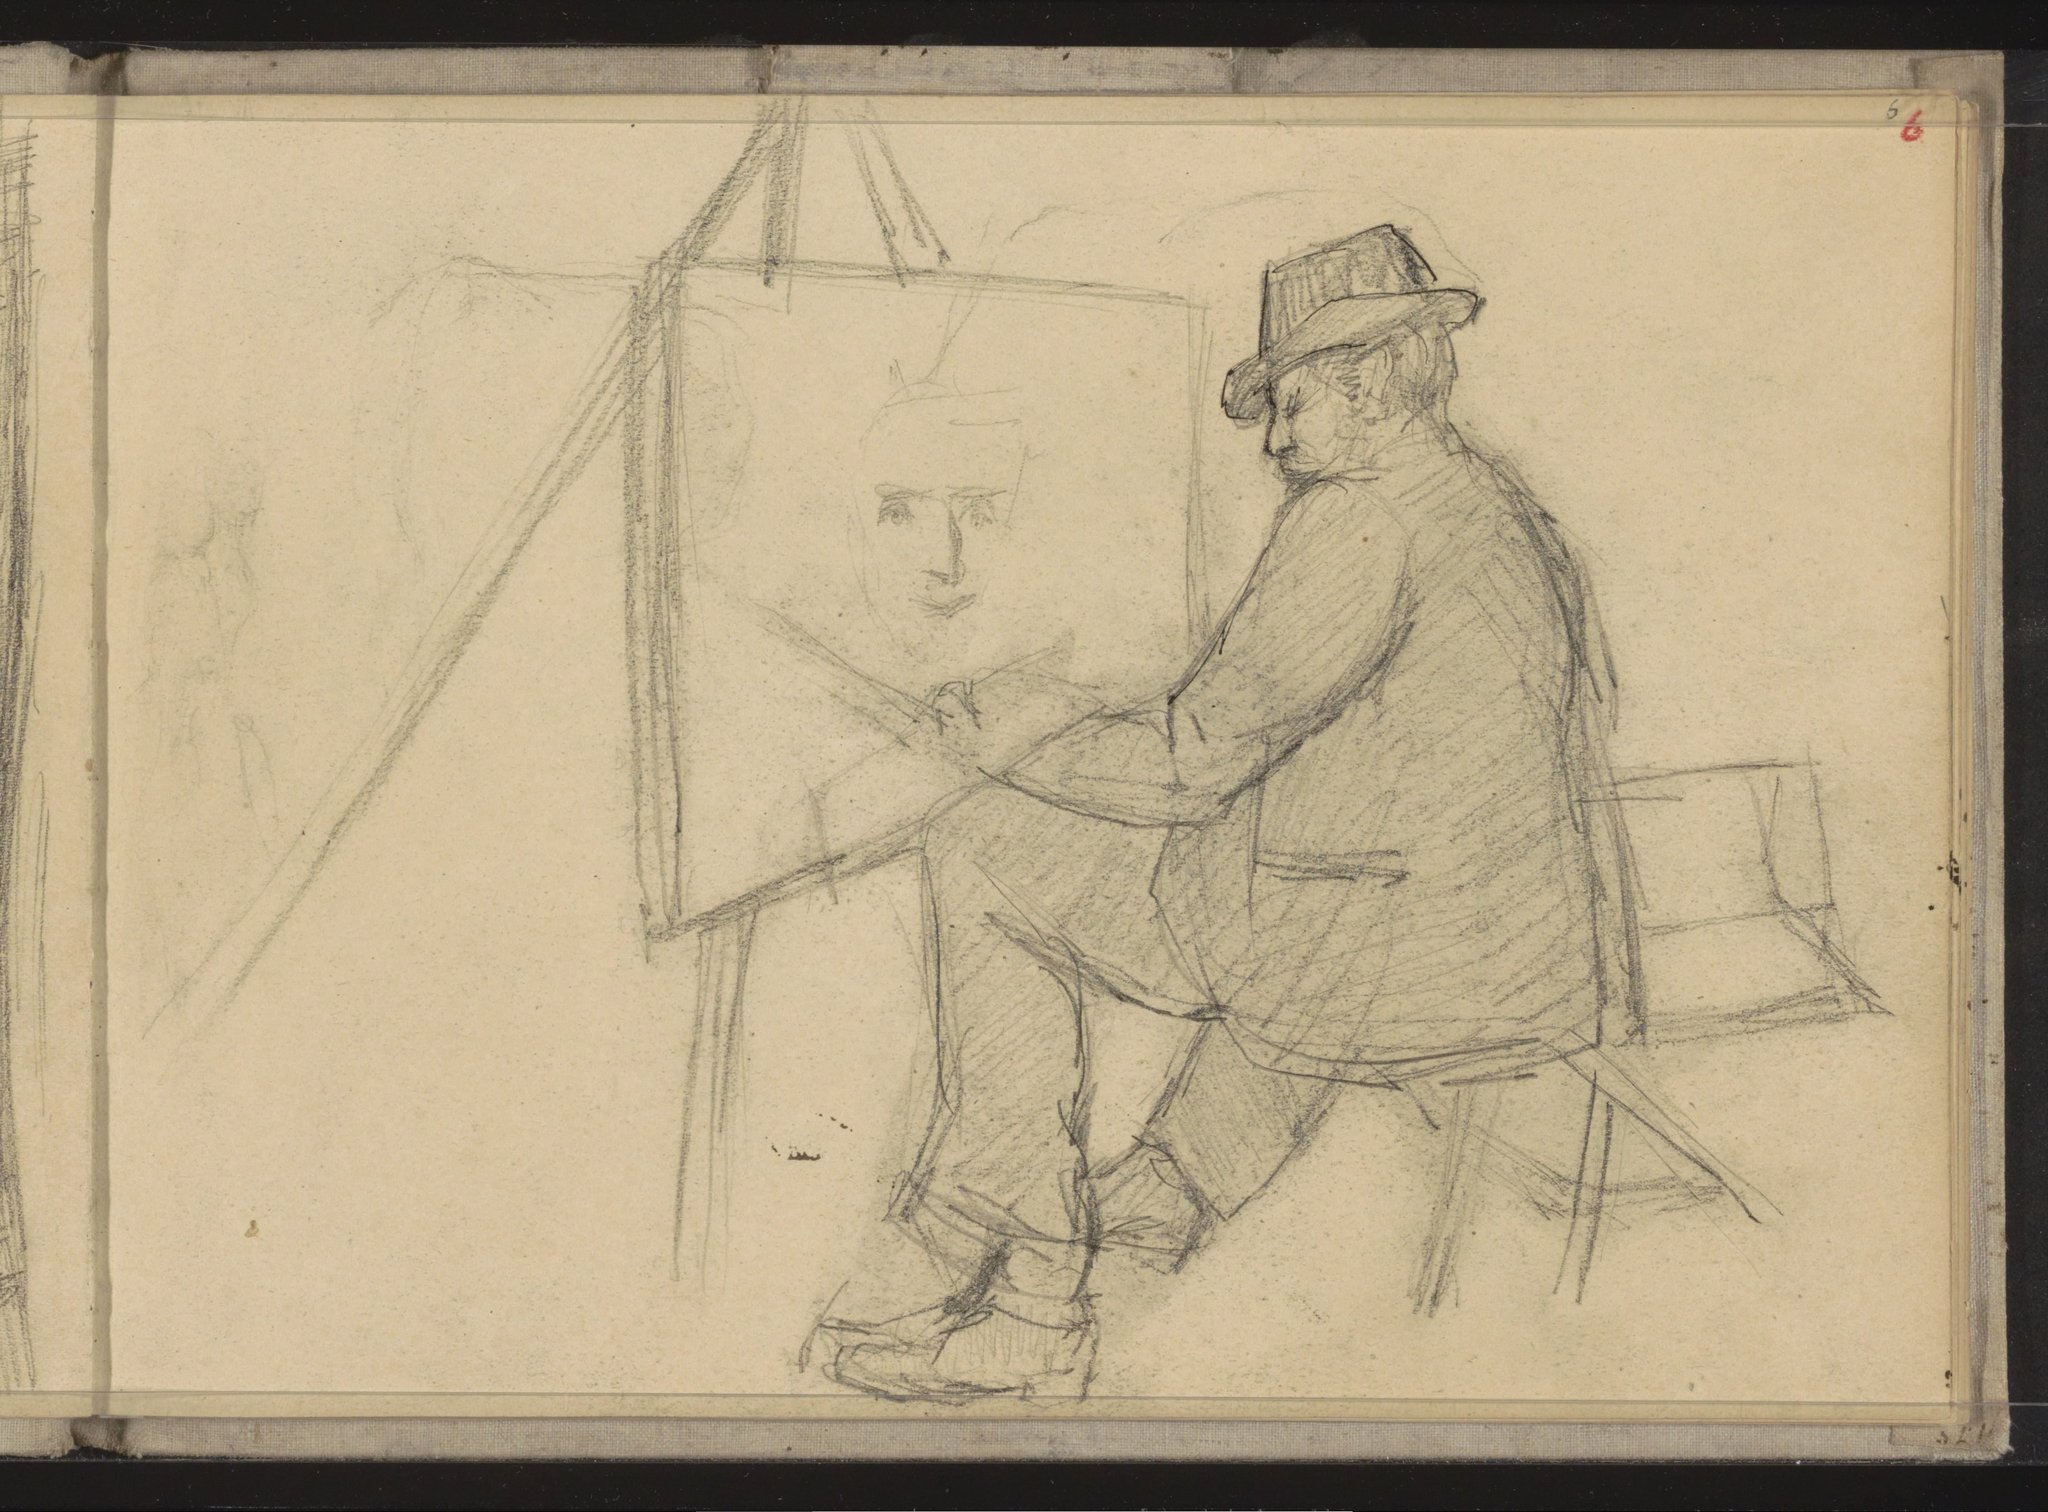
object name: sketchbook leaf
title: Kunstenaar zittend achter een schildersezel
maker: jozef israëls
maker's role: draughtsman, painter, print maker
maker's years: 1824-1911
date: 1834-1911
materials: ink, paper, pencil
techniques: pen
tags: artist at work, in his workshop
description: De man zit op een kruk en draagt een pak en hoge hoed. Op het doek voor hem is een kop te zien. Mogelijk een zelfportret. Blad 6 recto uit een schetsboek met 18 bladen.